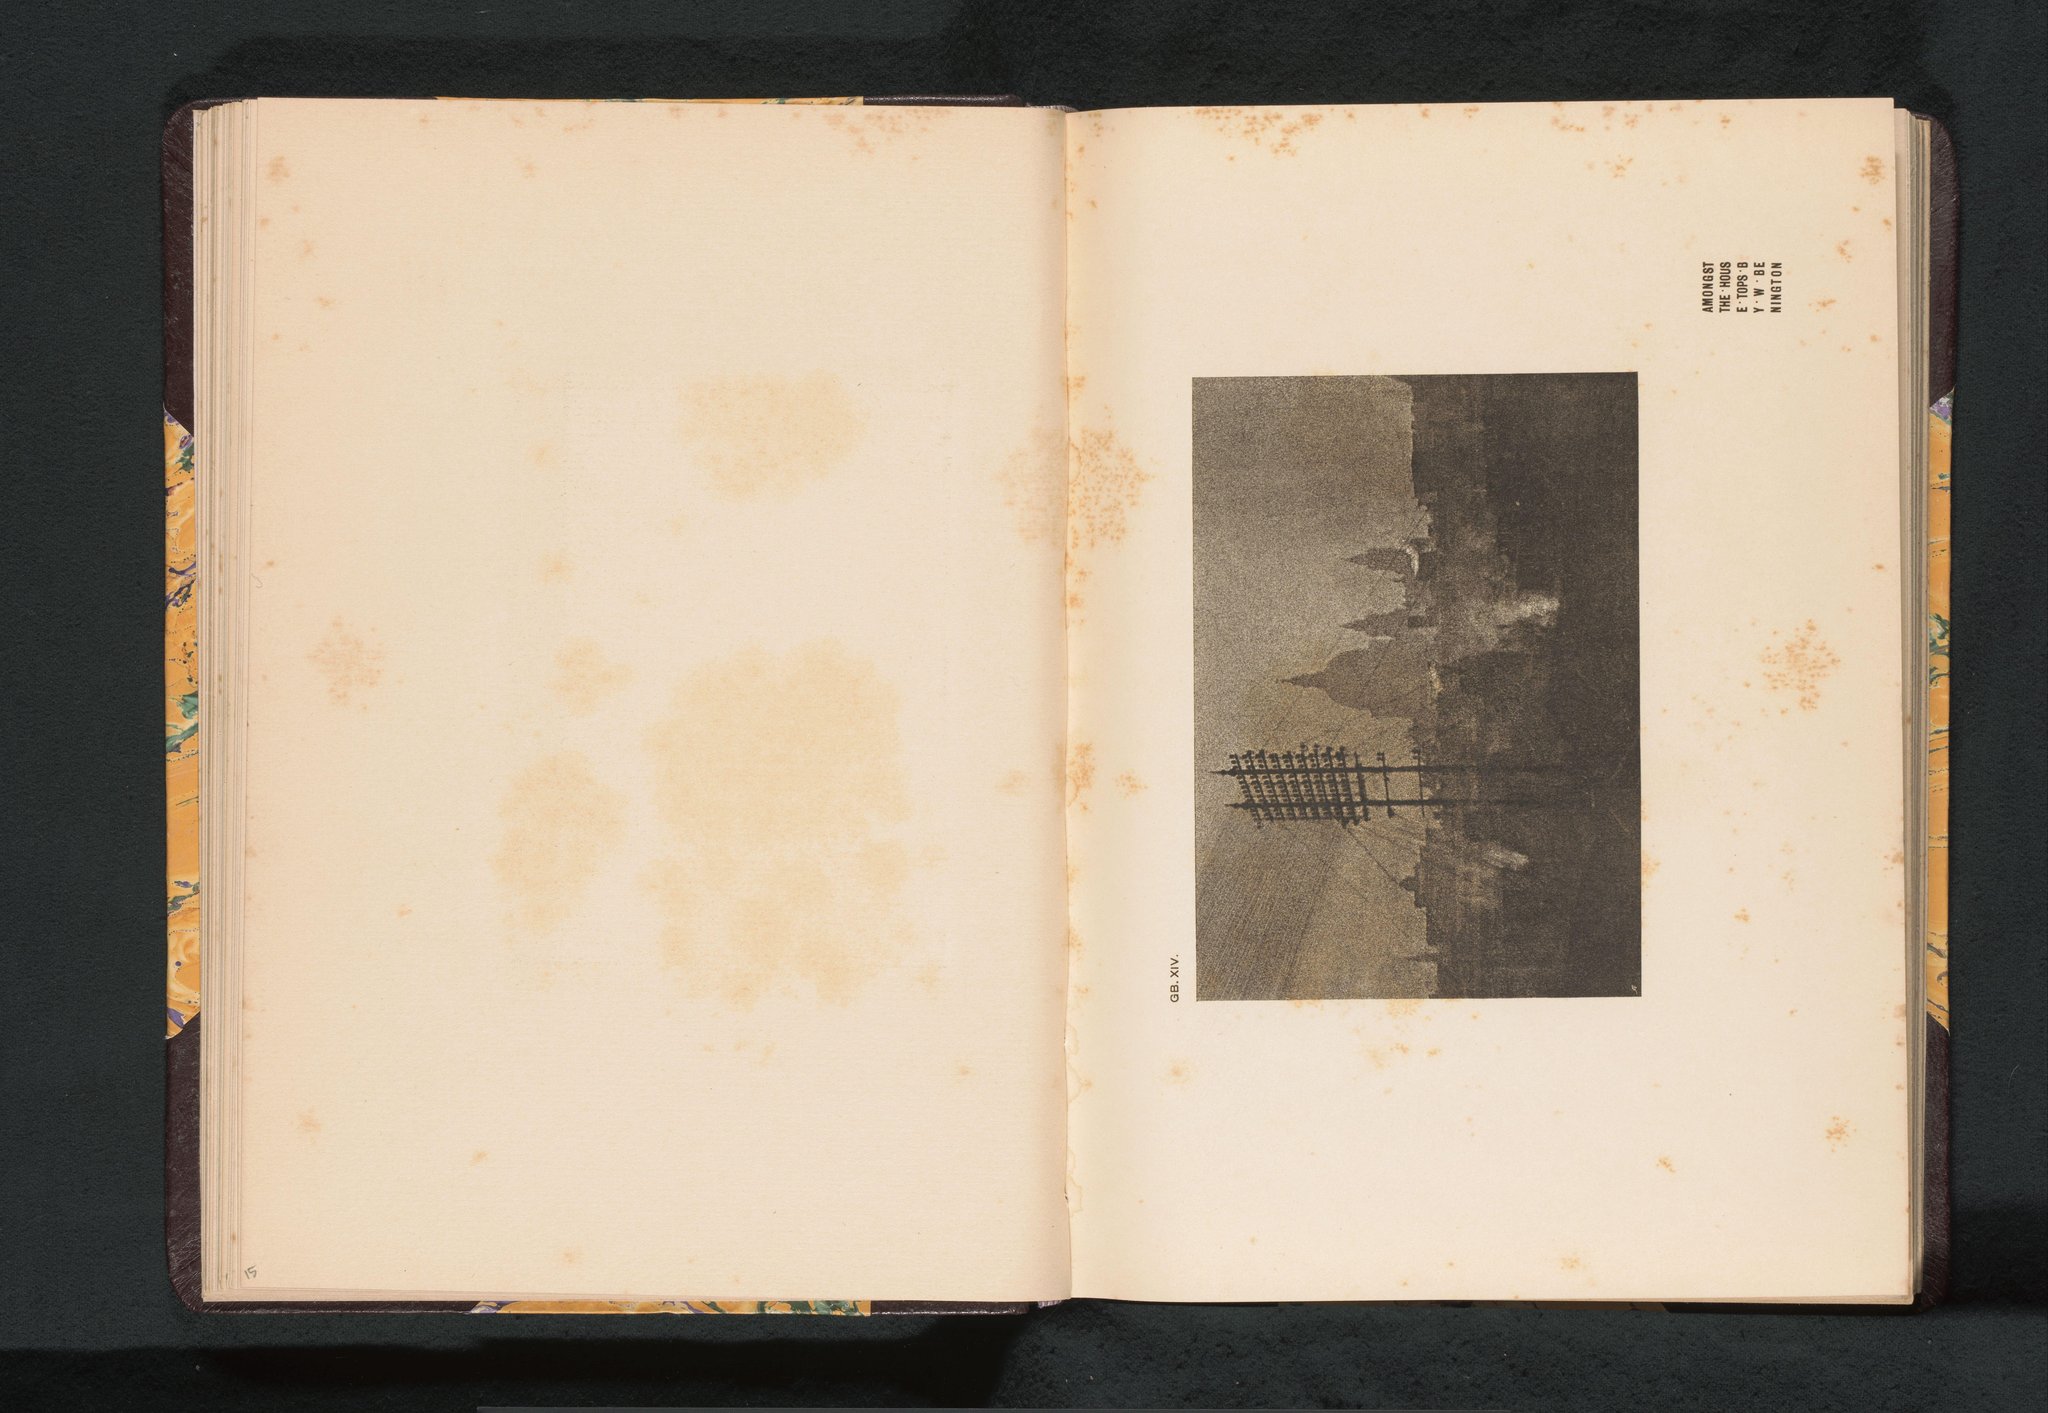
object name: photomechanical print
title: Silhouet van Londen met Saint Paul's Cathedral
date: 1900-1905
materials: paper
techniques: collo-autotype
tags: city-view in general; 'veduta', church (exterior), london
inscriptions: inscription: ‘Amongst the house tops by W. Benington’, inscription: ‘GB. XIV.’, monogram: ‘AG’